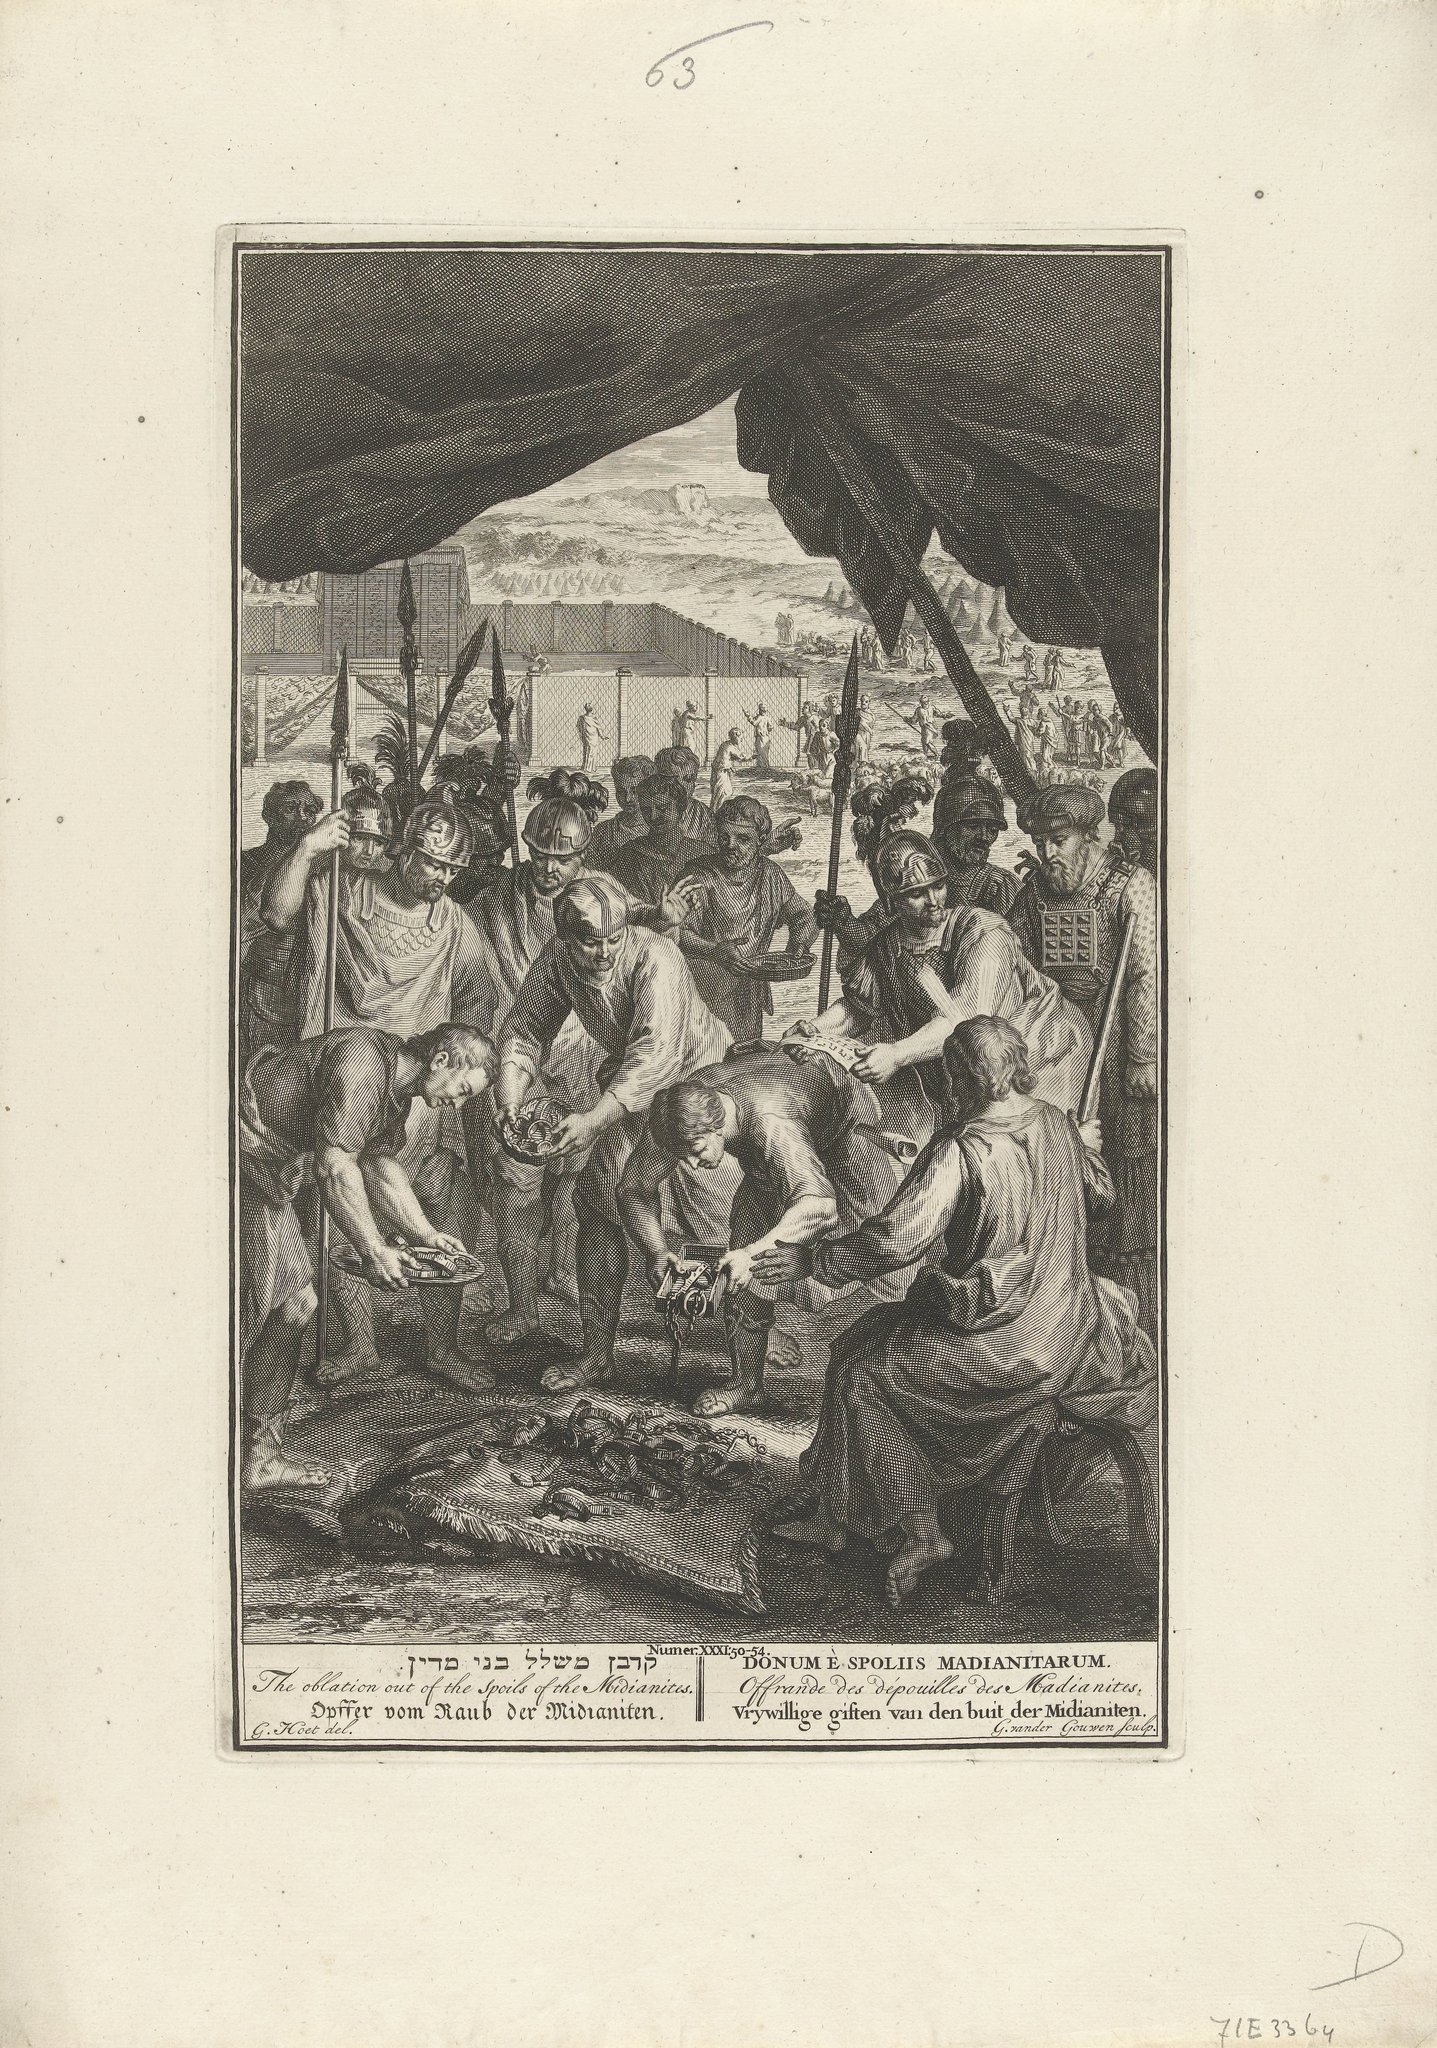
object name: book illustration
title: Offerande van de buit van de Midjanieten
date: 1728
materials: paper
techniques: engraving, etching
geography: the hague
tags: the officer's oblation after the battle of the israelites against the midianites; moses and eleazar take the gifts to the tabernacle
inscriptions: collector's mark: Lugt 2228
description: Mozes en de priester Eleazar nemen de gouden sieraden uit de buit van de Midjanieten aan als offerande voor God (Num. 31:50-54). De prent heeft een Hebreeuws, Latijns, Frans, Engels, Duits en Nederlands onderschrift.